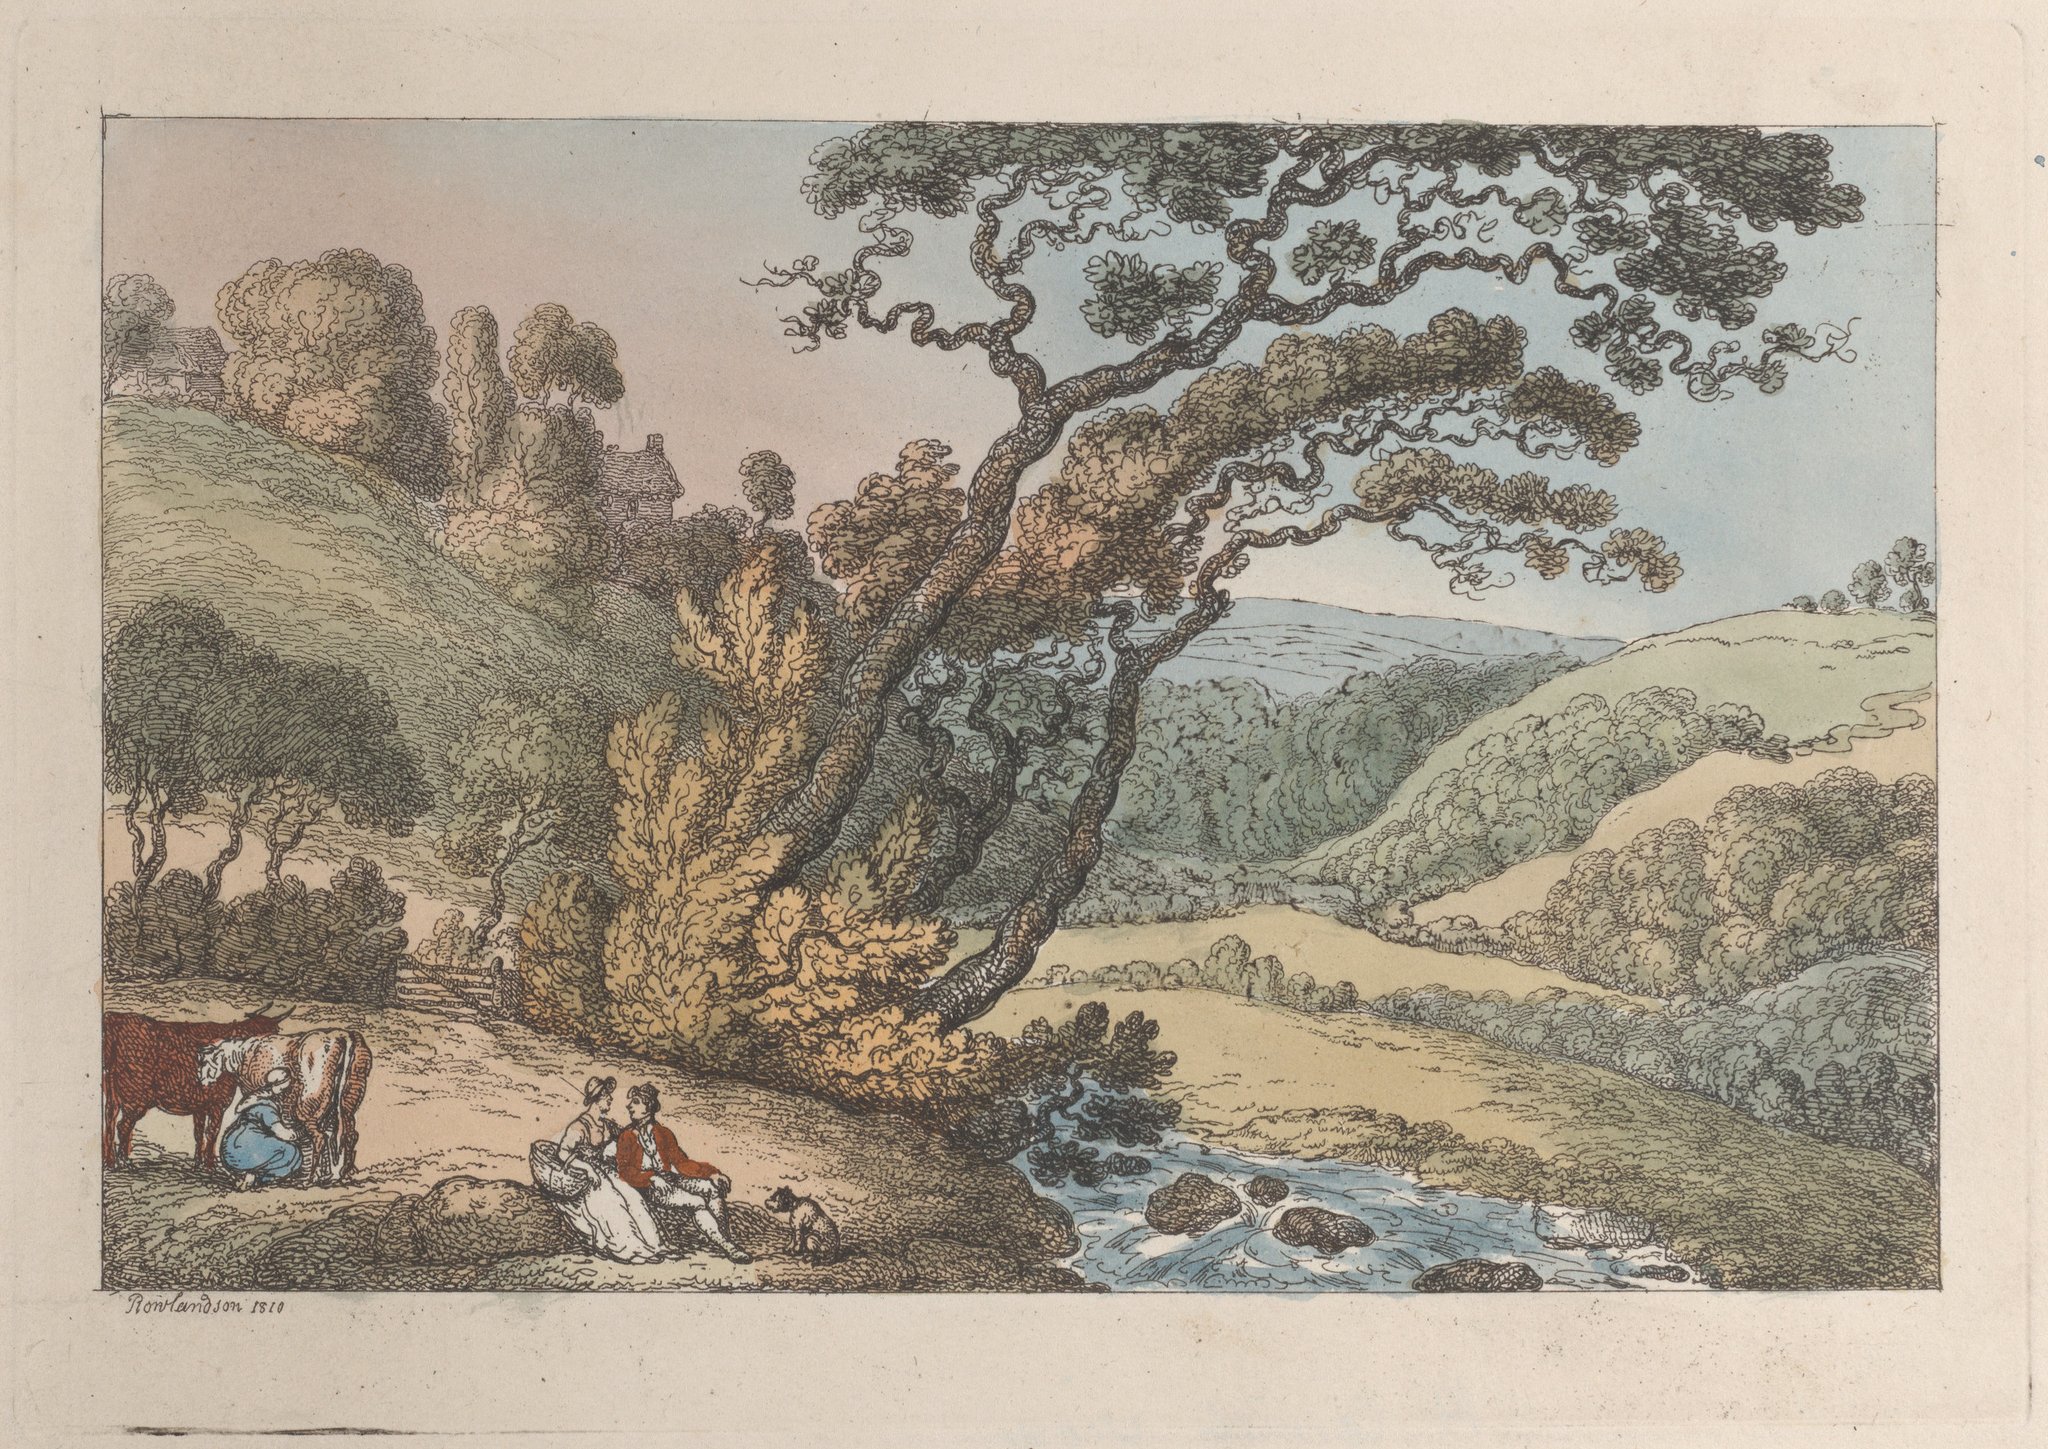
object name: print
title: A Cornish View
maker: thomas rowlandson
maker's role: artist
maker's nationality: british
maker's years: 1757-1827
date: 1810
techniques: etching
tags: landscapes